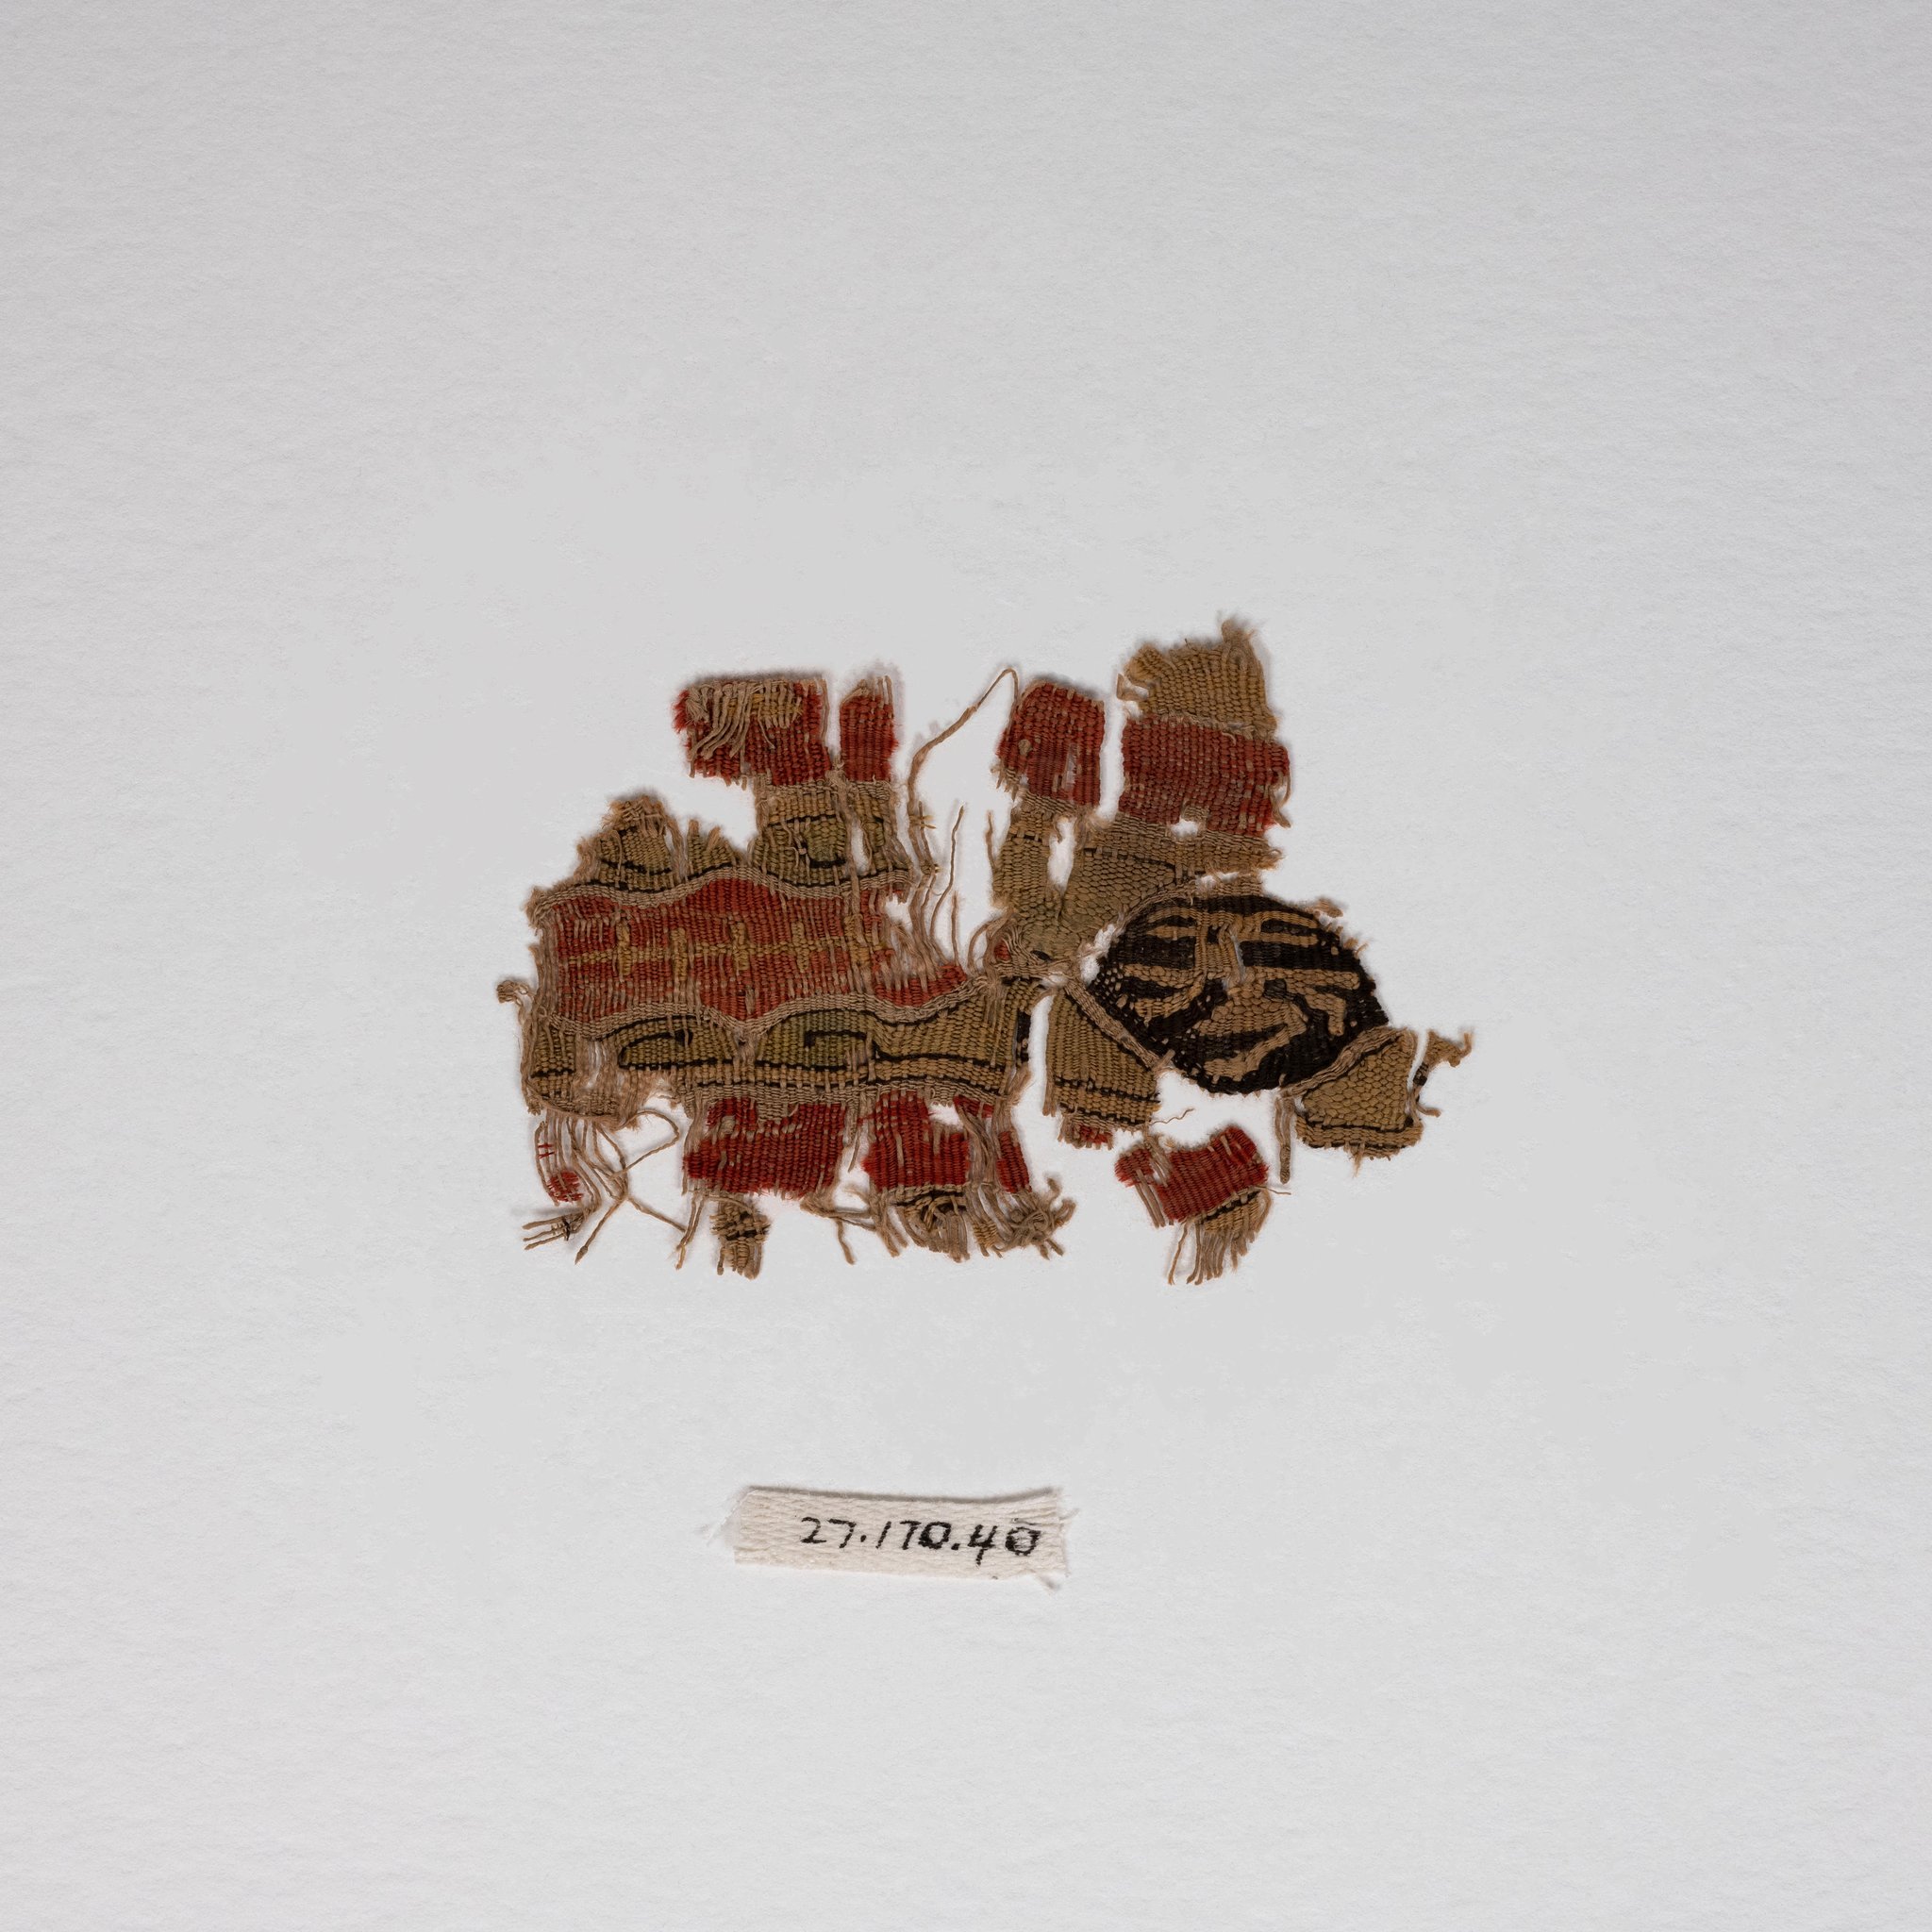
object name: textile fragment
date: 1101-1200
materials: linen, silk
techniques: tapestry, weave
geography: egypt